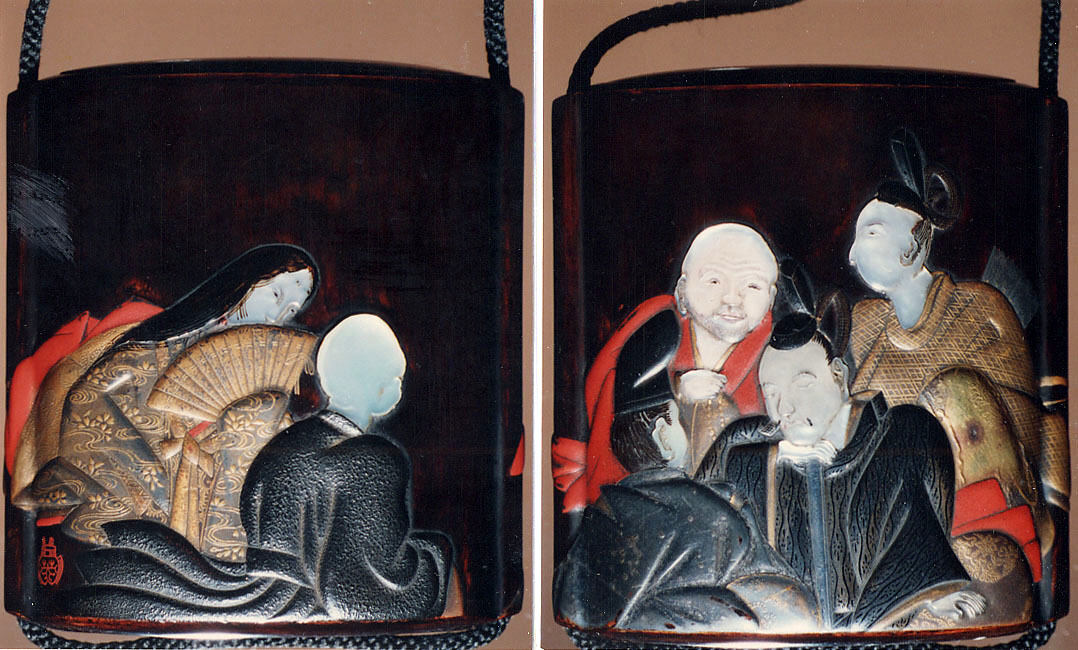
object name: inrō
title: Case (Inrō) with Design of Six Immortal Poets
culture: japanese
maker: kajikawa school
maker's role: artist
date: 1801-1900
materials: bronze, gold, lacquer, mother of pearl, silver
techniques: carving, inlay, maki, relief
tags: men,women,poets